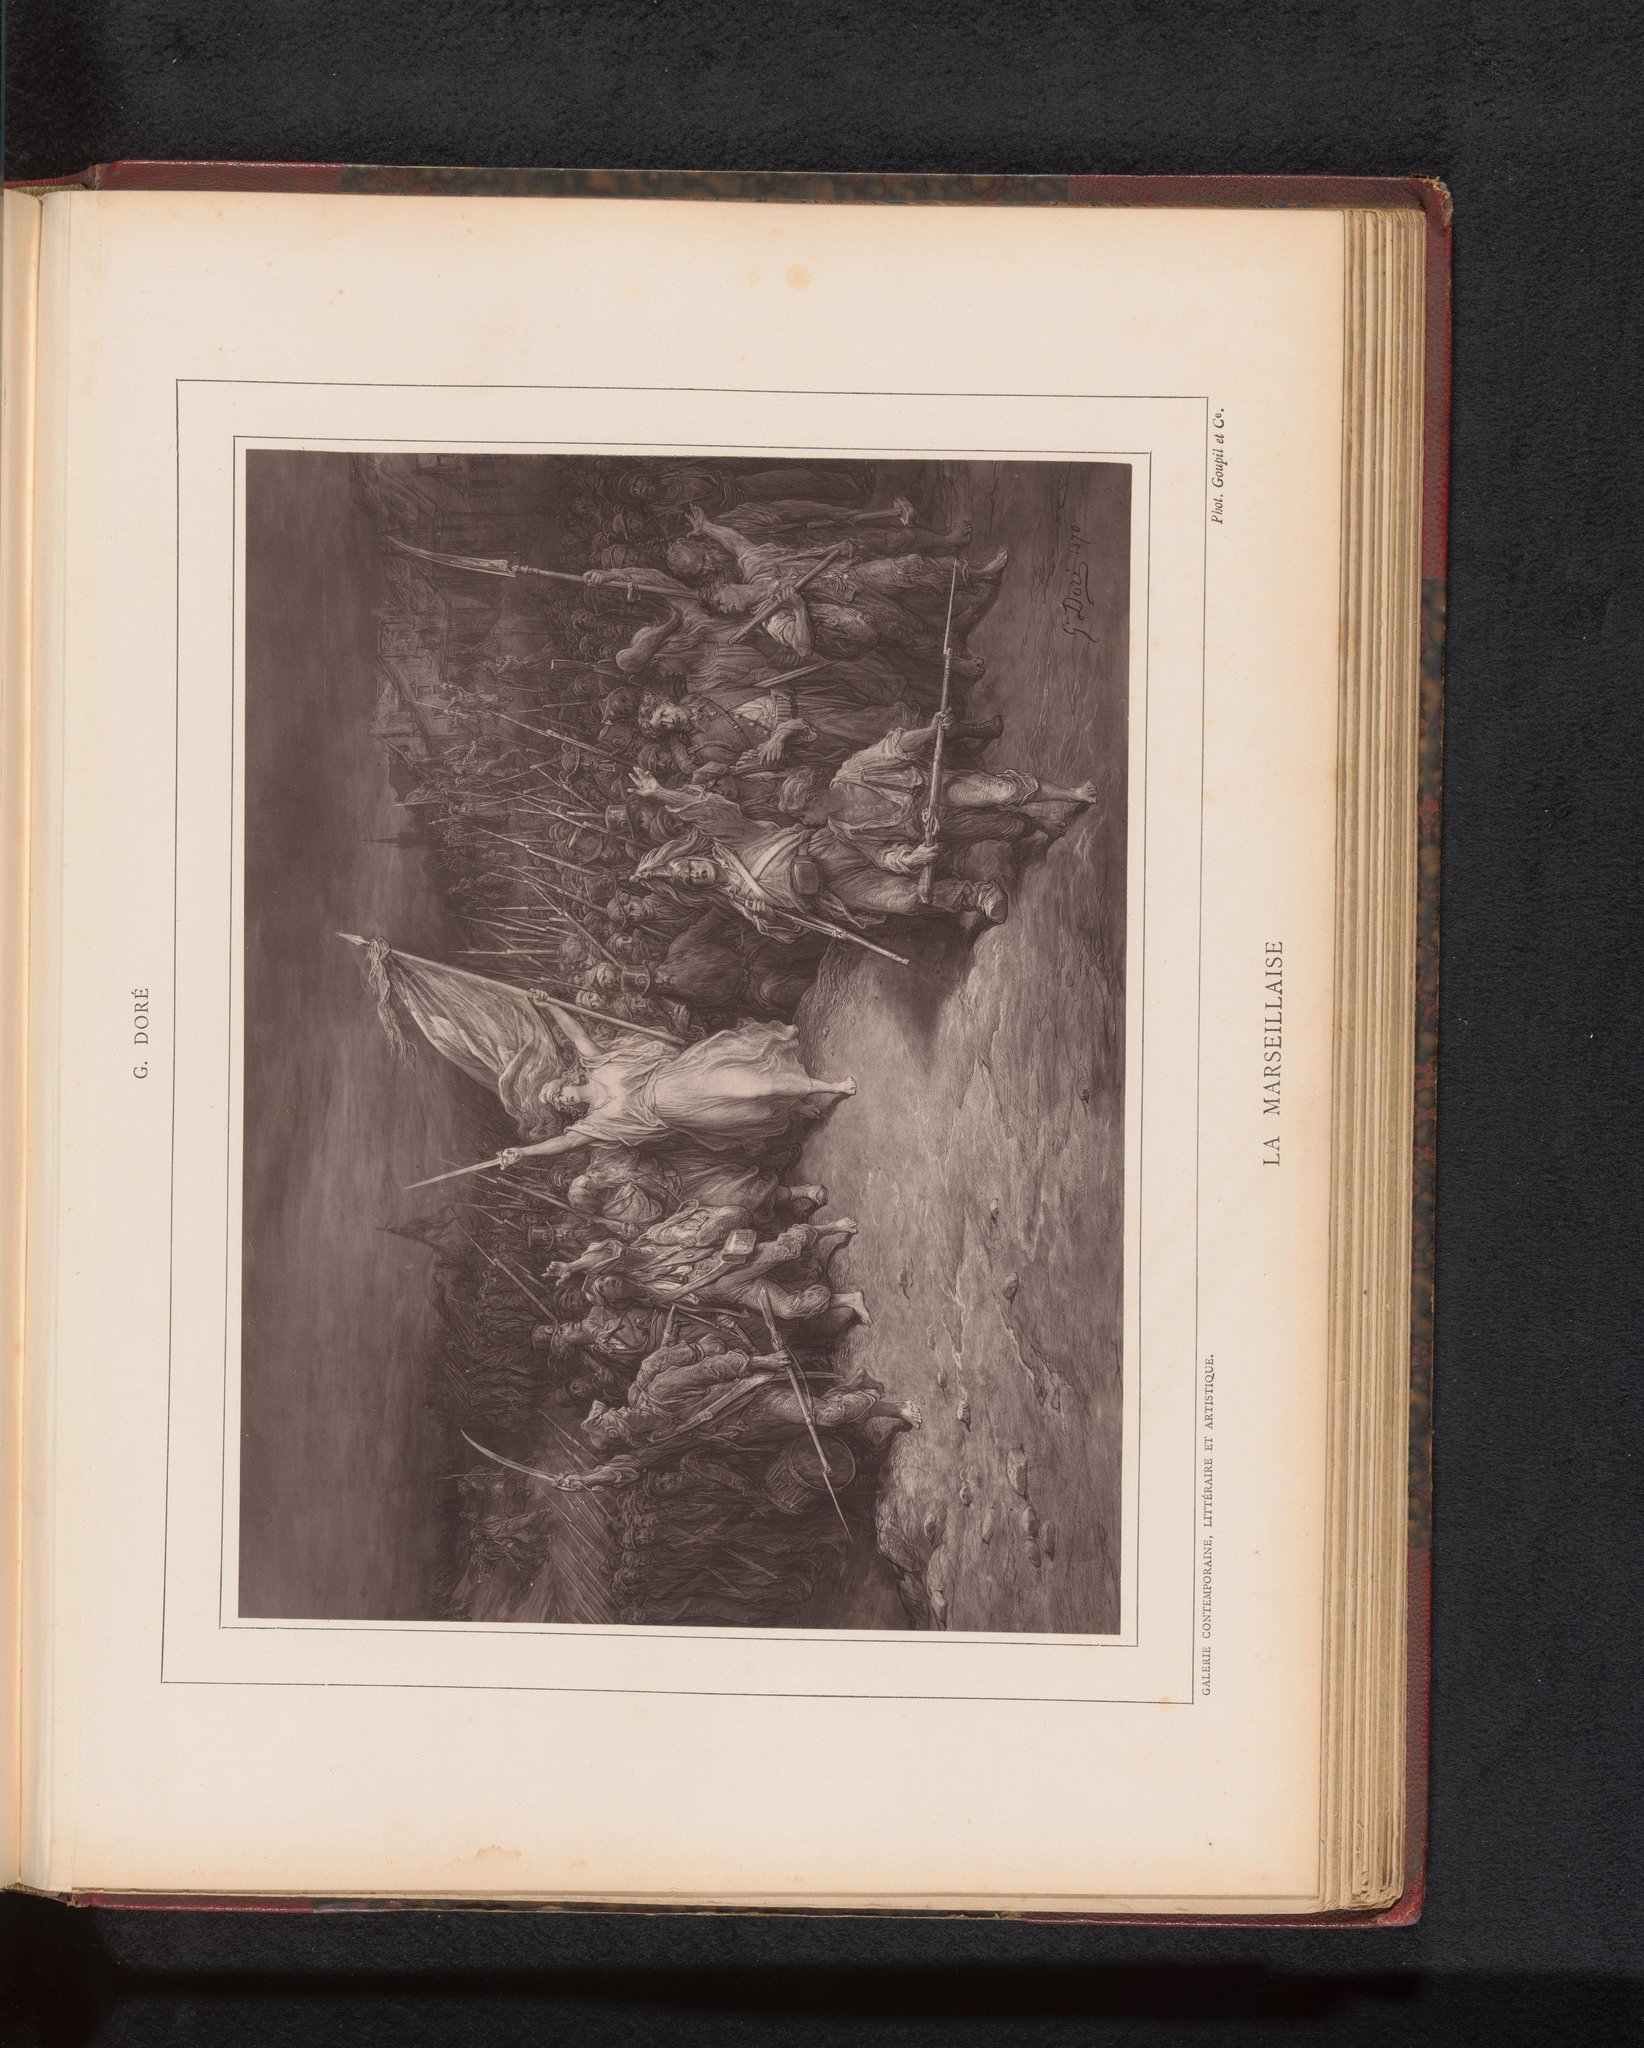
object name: reproduction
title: La Marseillaise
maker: gustave doré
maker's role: draughtsman, print maker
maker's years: 1832-1883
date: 1878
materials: paper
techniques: woodburytype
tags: crowd, mob, vocal music, singing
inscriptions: inscription: ‘Galerie Contemporaine, Littéraire et Artistique.’